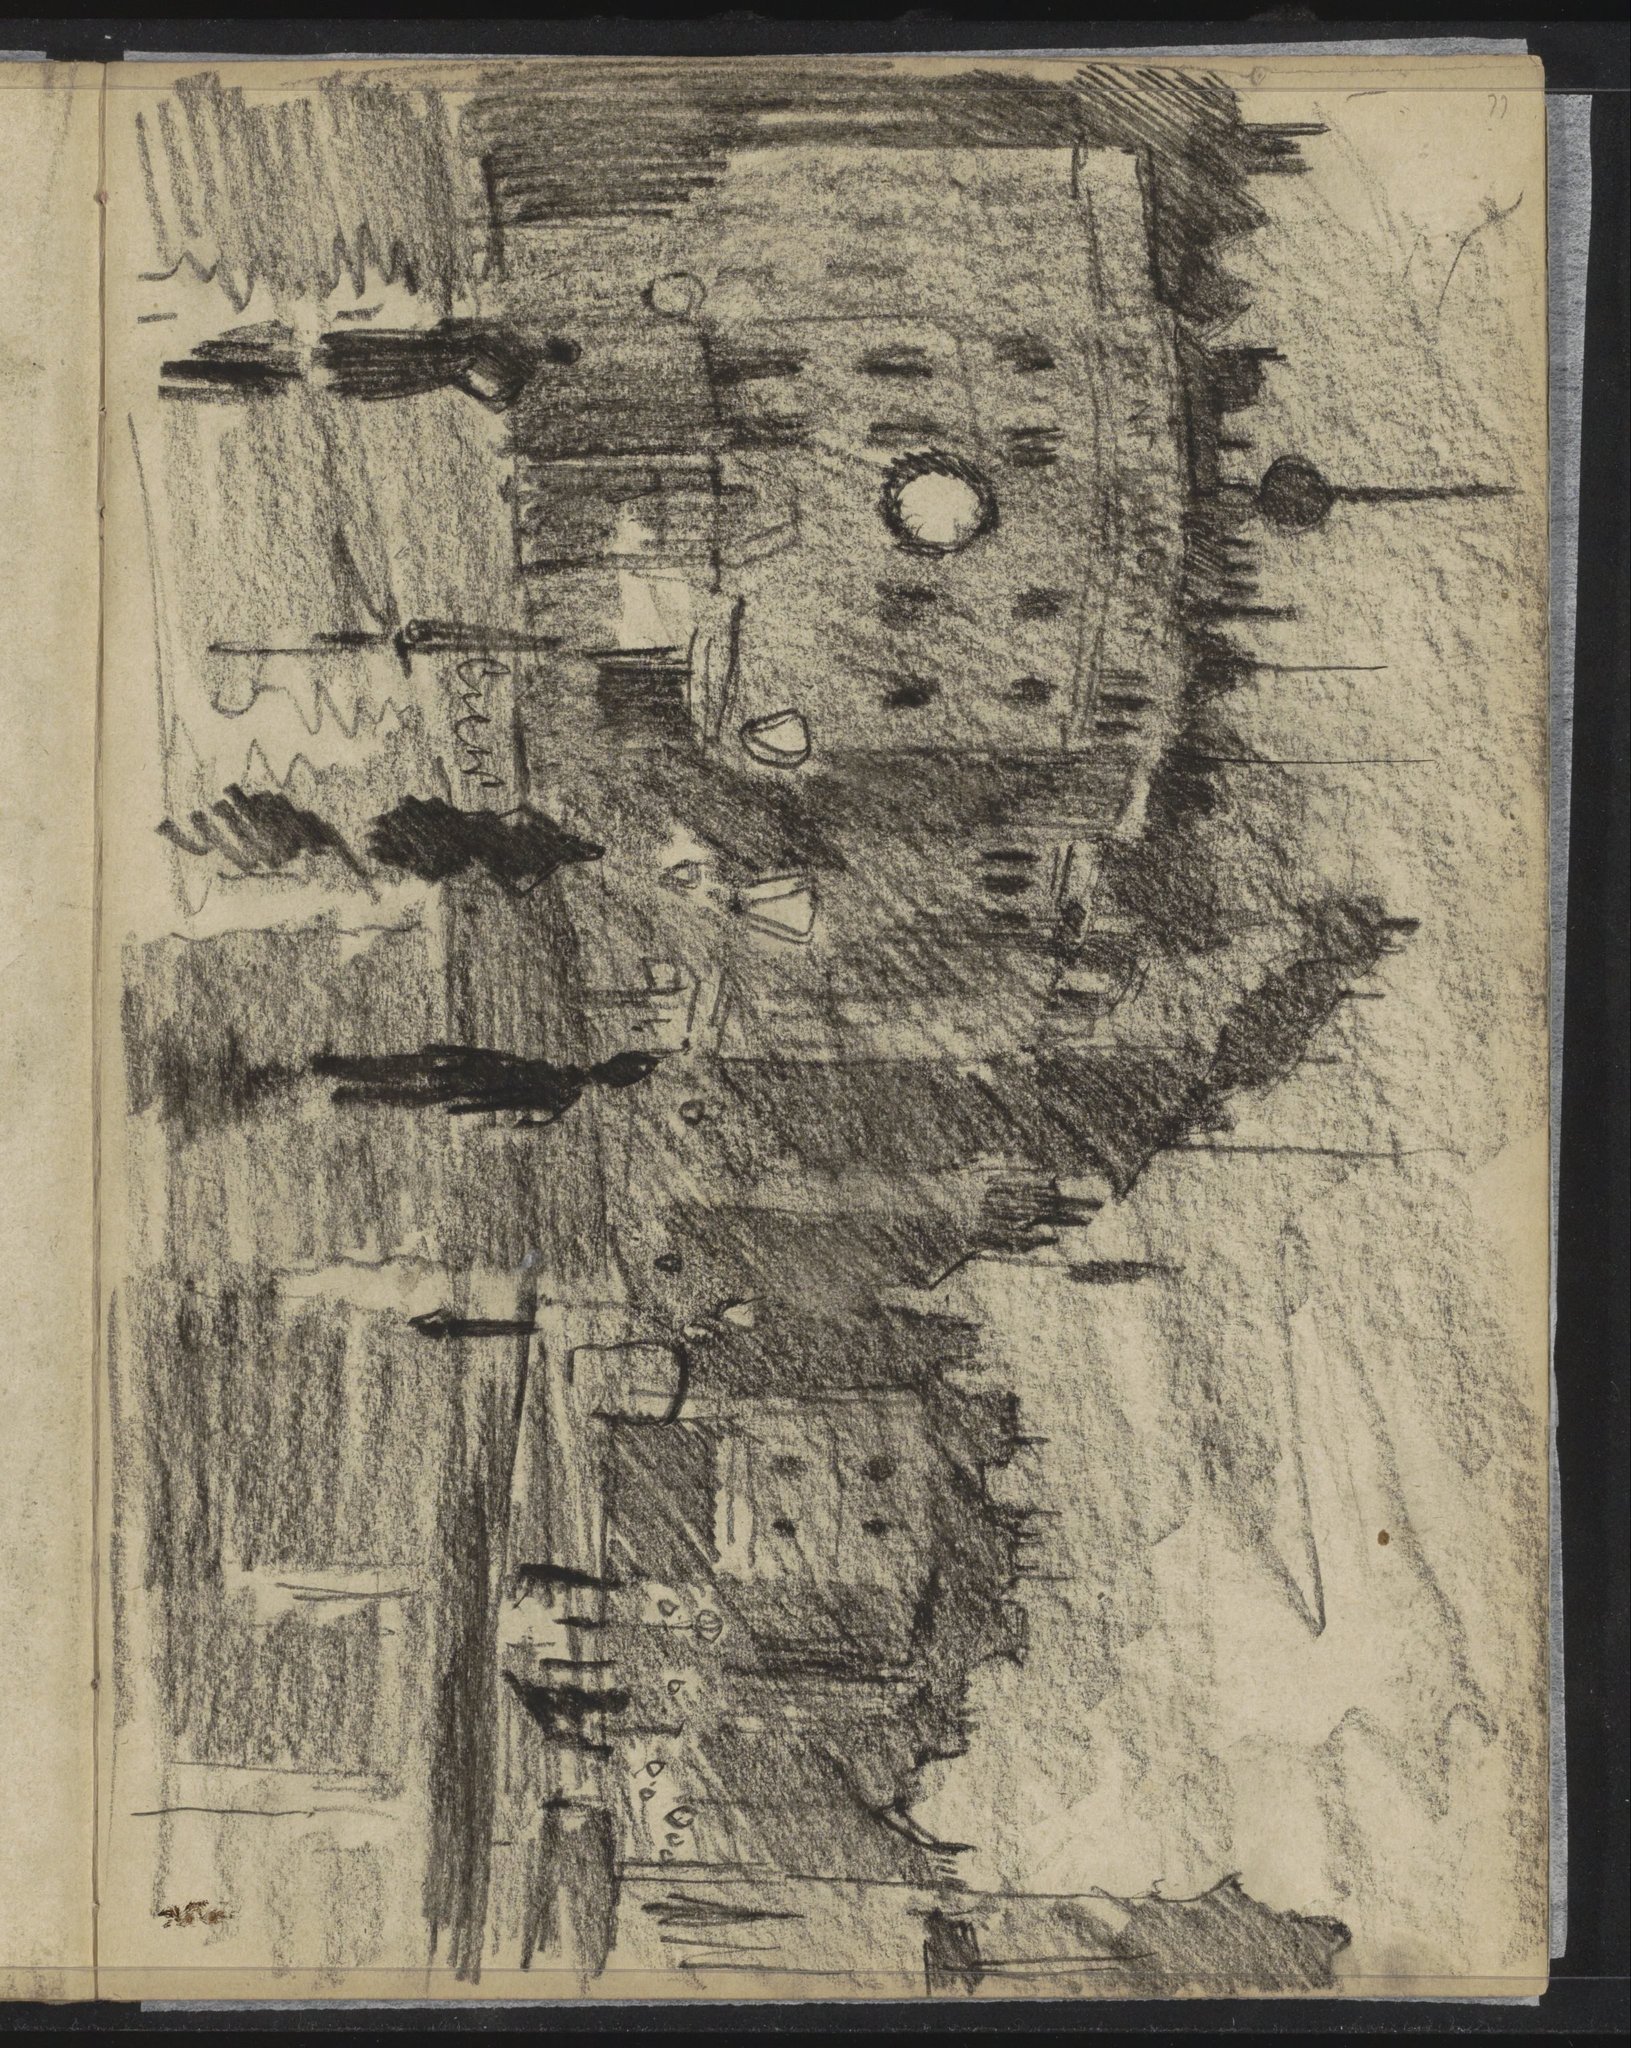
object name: sketchbook leaf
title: Gezicht in Londen, mogelijk de hoek van Trafalgar Square en A4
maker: willem witsen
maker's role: draughtsman, painter, print maker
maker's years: 1860-1923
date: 1888-1891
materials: chalk, paper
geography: london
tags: civic architecture; edifices; dwellings, square, place, circus, etc. (+ city(-scape) with figures, staffage), street (+ city(-scape) with figures, staffage)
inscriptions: kleurnotitie, handgeschreven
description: Mogelijk met het voormalige gebouw van de Cunard Steamship Company, het huidige Trafalgar Hotel. Pagina 77 uit een schetsboek met 49 bladen.